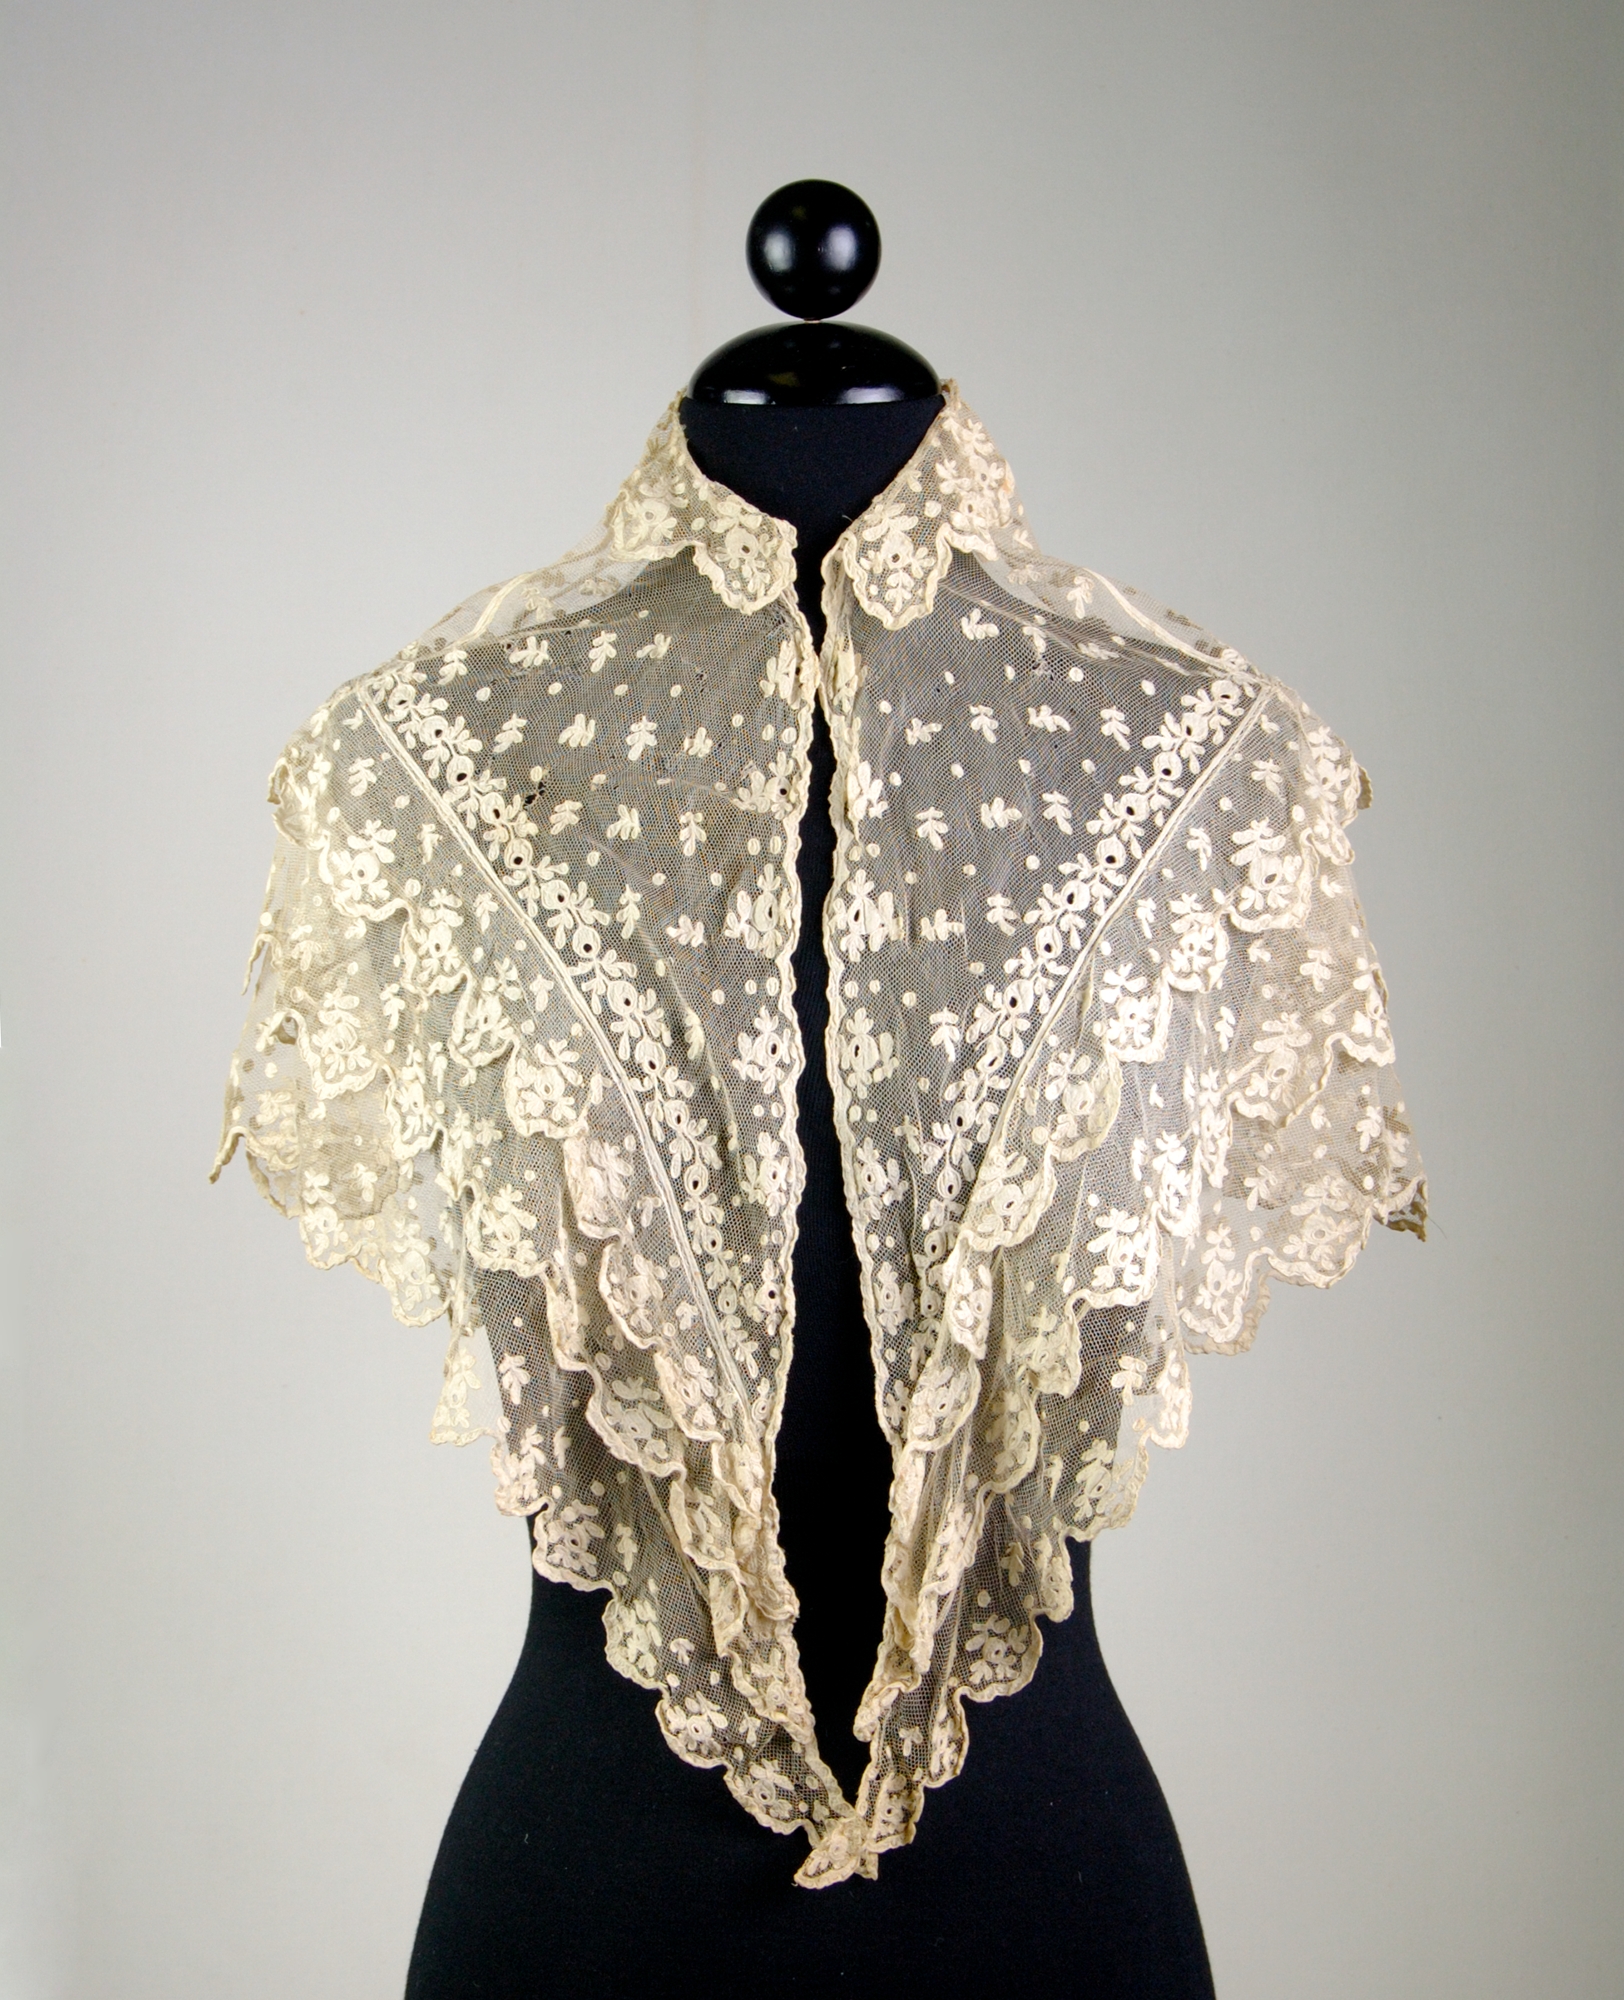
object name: pelerine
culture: irish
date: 1830-1840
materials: cotton